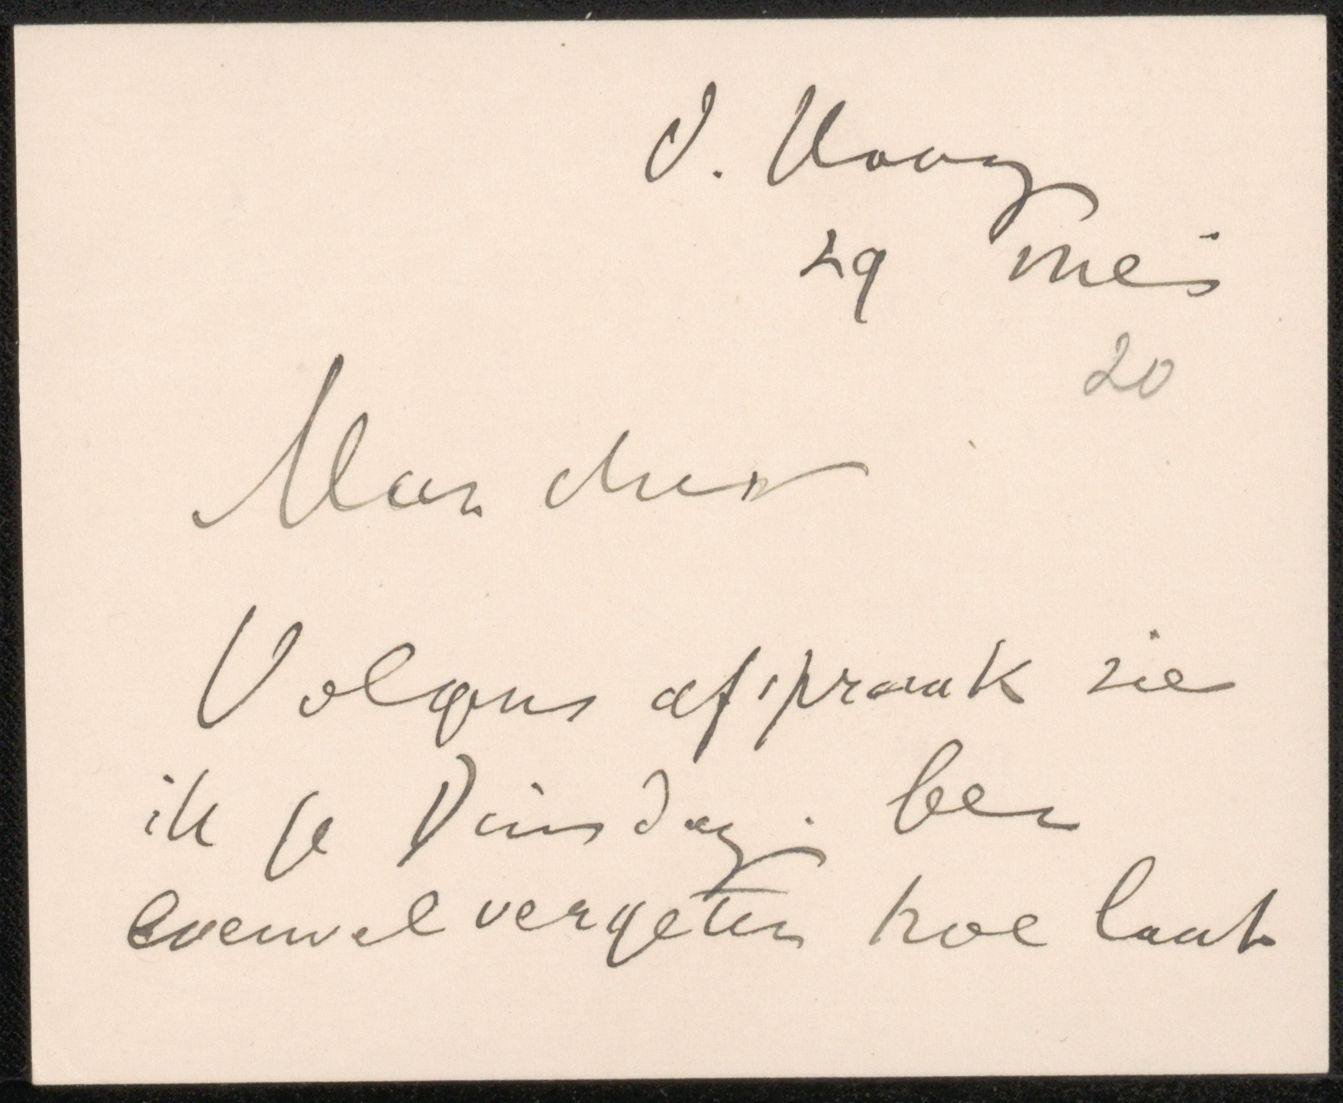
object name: letter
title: Brief aan Jan Veth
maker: isaac israels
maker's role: draughtsman, painter, print maker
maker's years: 1865-1934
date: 1875-1925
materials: ink, paper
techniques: pen, writing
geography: the hague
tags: painter, print maker, draughtsman, designer, jan veth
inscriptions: collector's mark: ‘RPK’